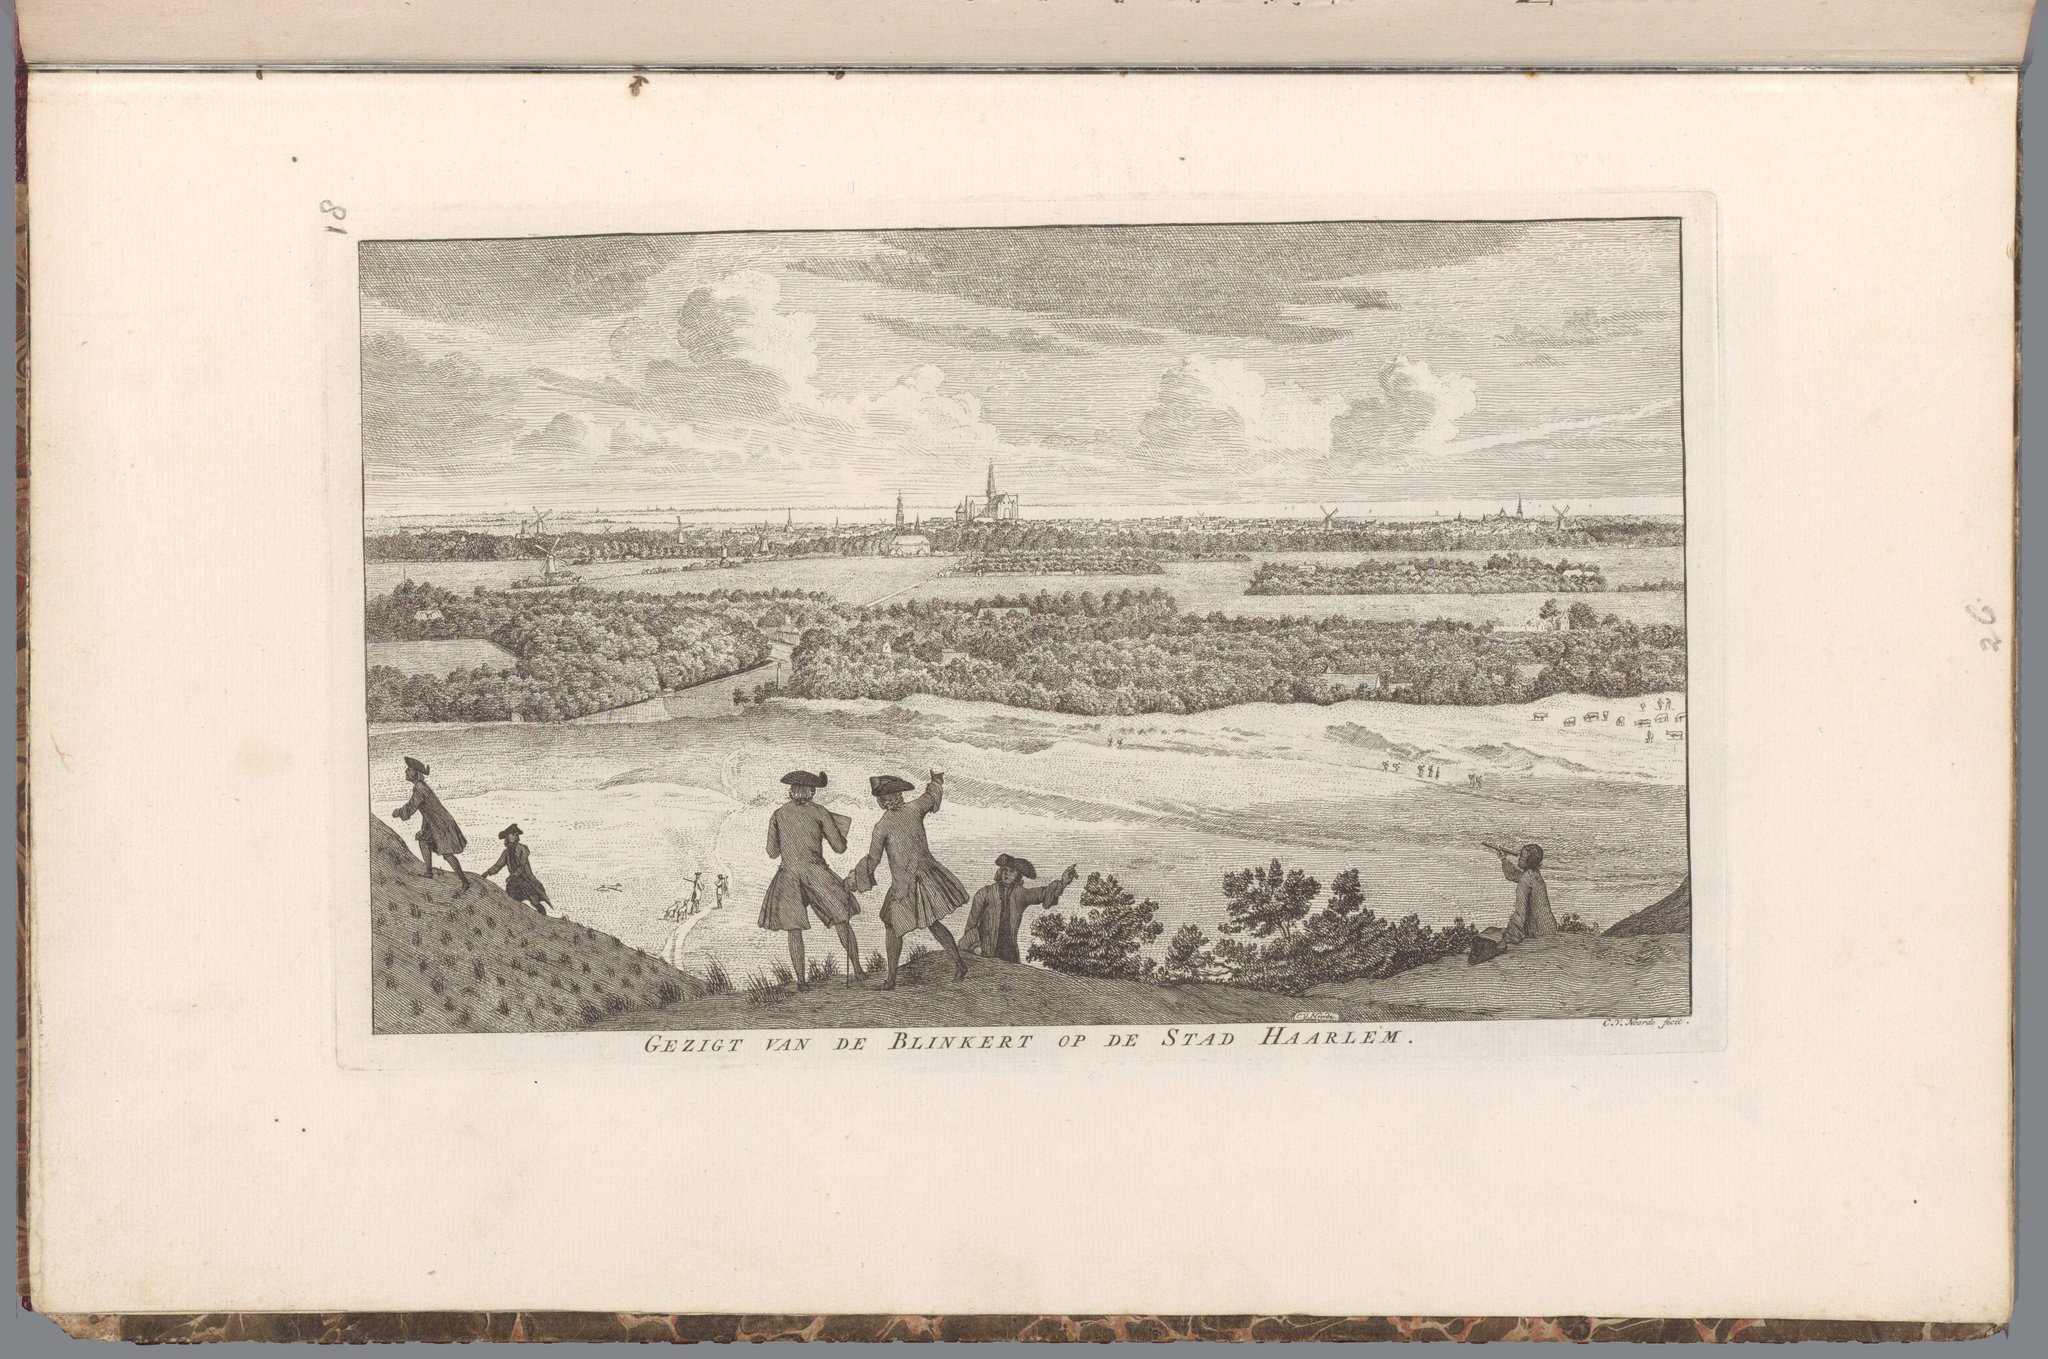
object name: album leaf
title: Gezigt van de Blinkert op de Stad Haarlem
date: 1763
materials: paper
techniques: etching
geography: haarlem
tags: city-view in general; 'veduta', dunes (sea not visible); in the dunes, haarlem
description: Uitzicht vanaf het duin De Blinkert op de stad Haarlem. Op het duin enkele mannen, waarvan een met een verrekijker. Deze prent maakt deel uit van een album.